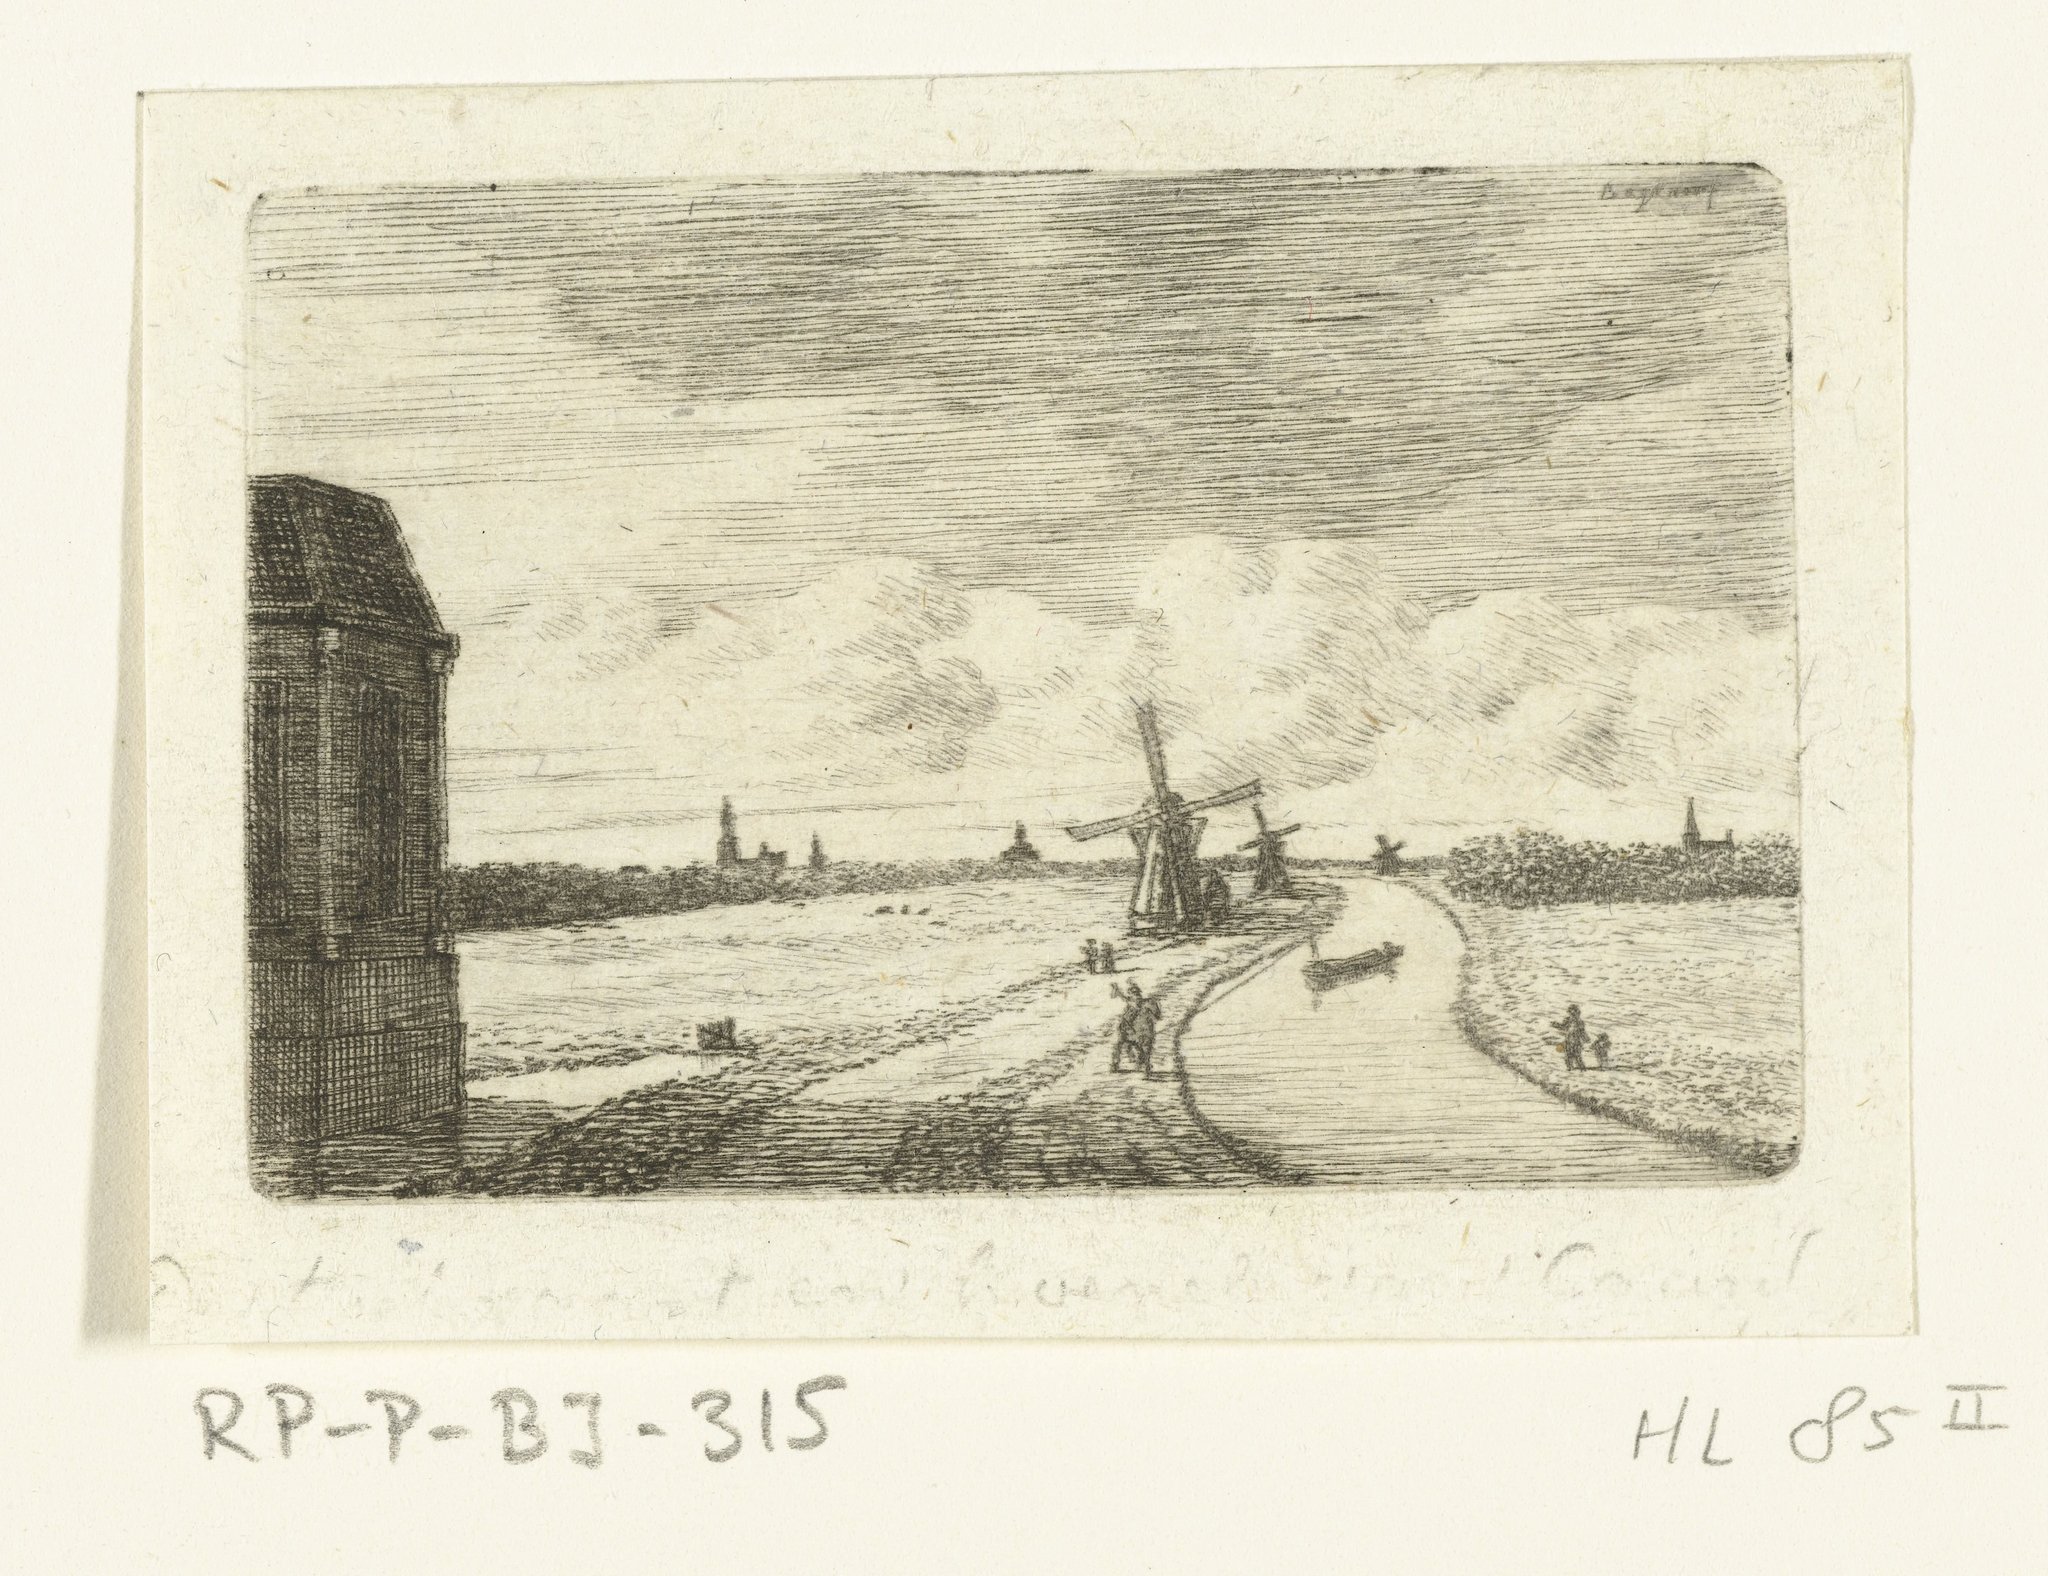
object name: print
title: Gezicht op de Haagsche vaart met molens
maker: ernst willem jan bagelaar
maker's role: draughtsman, print maker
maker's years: 1775-1837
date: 1798-1837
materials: paper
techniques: drypoint, etching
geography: netherlands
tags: windmill in landscape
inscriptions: collector's mark: Lugt 2228